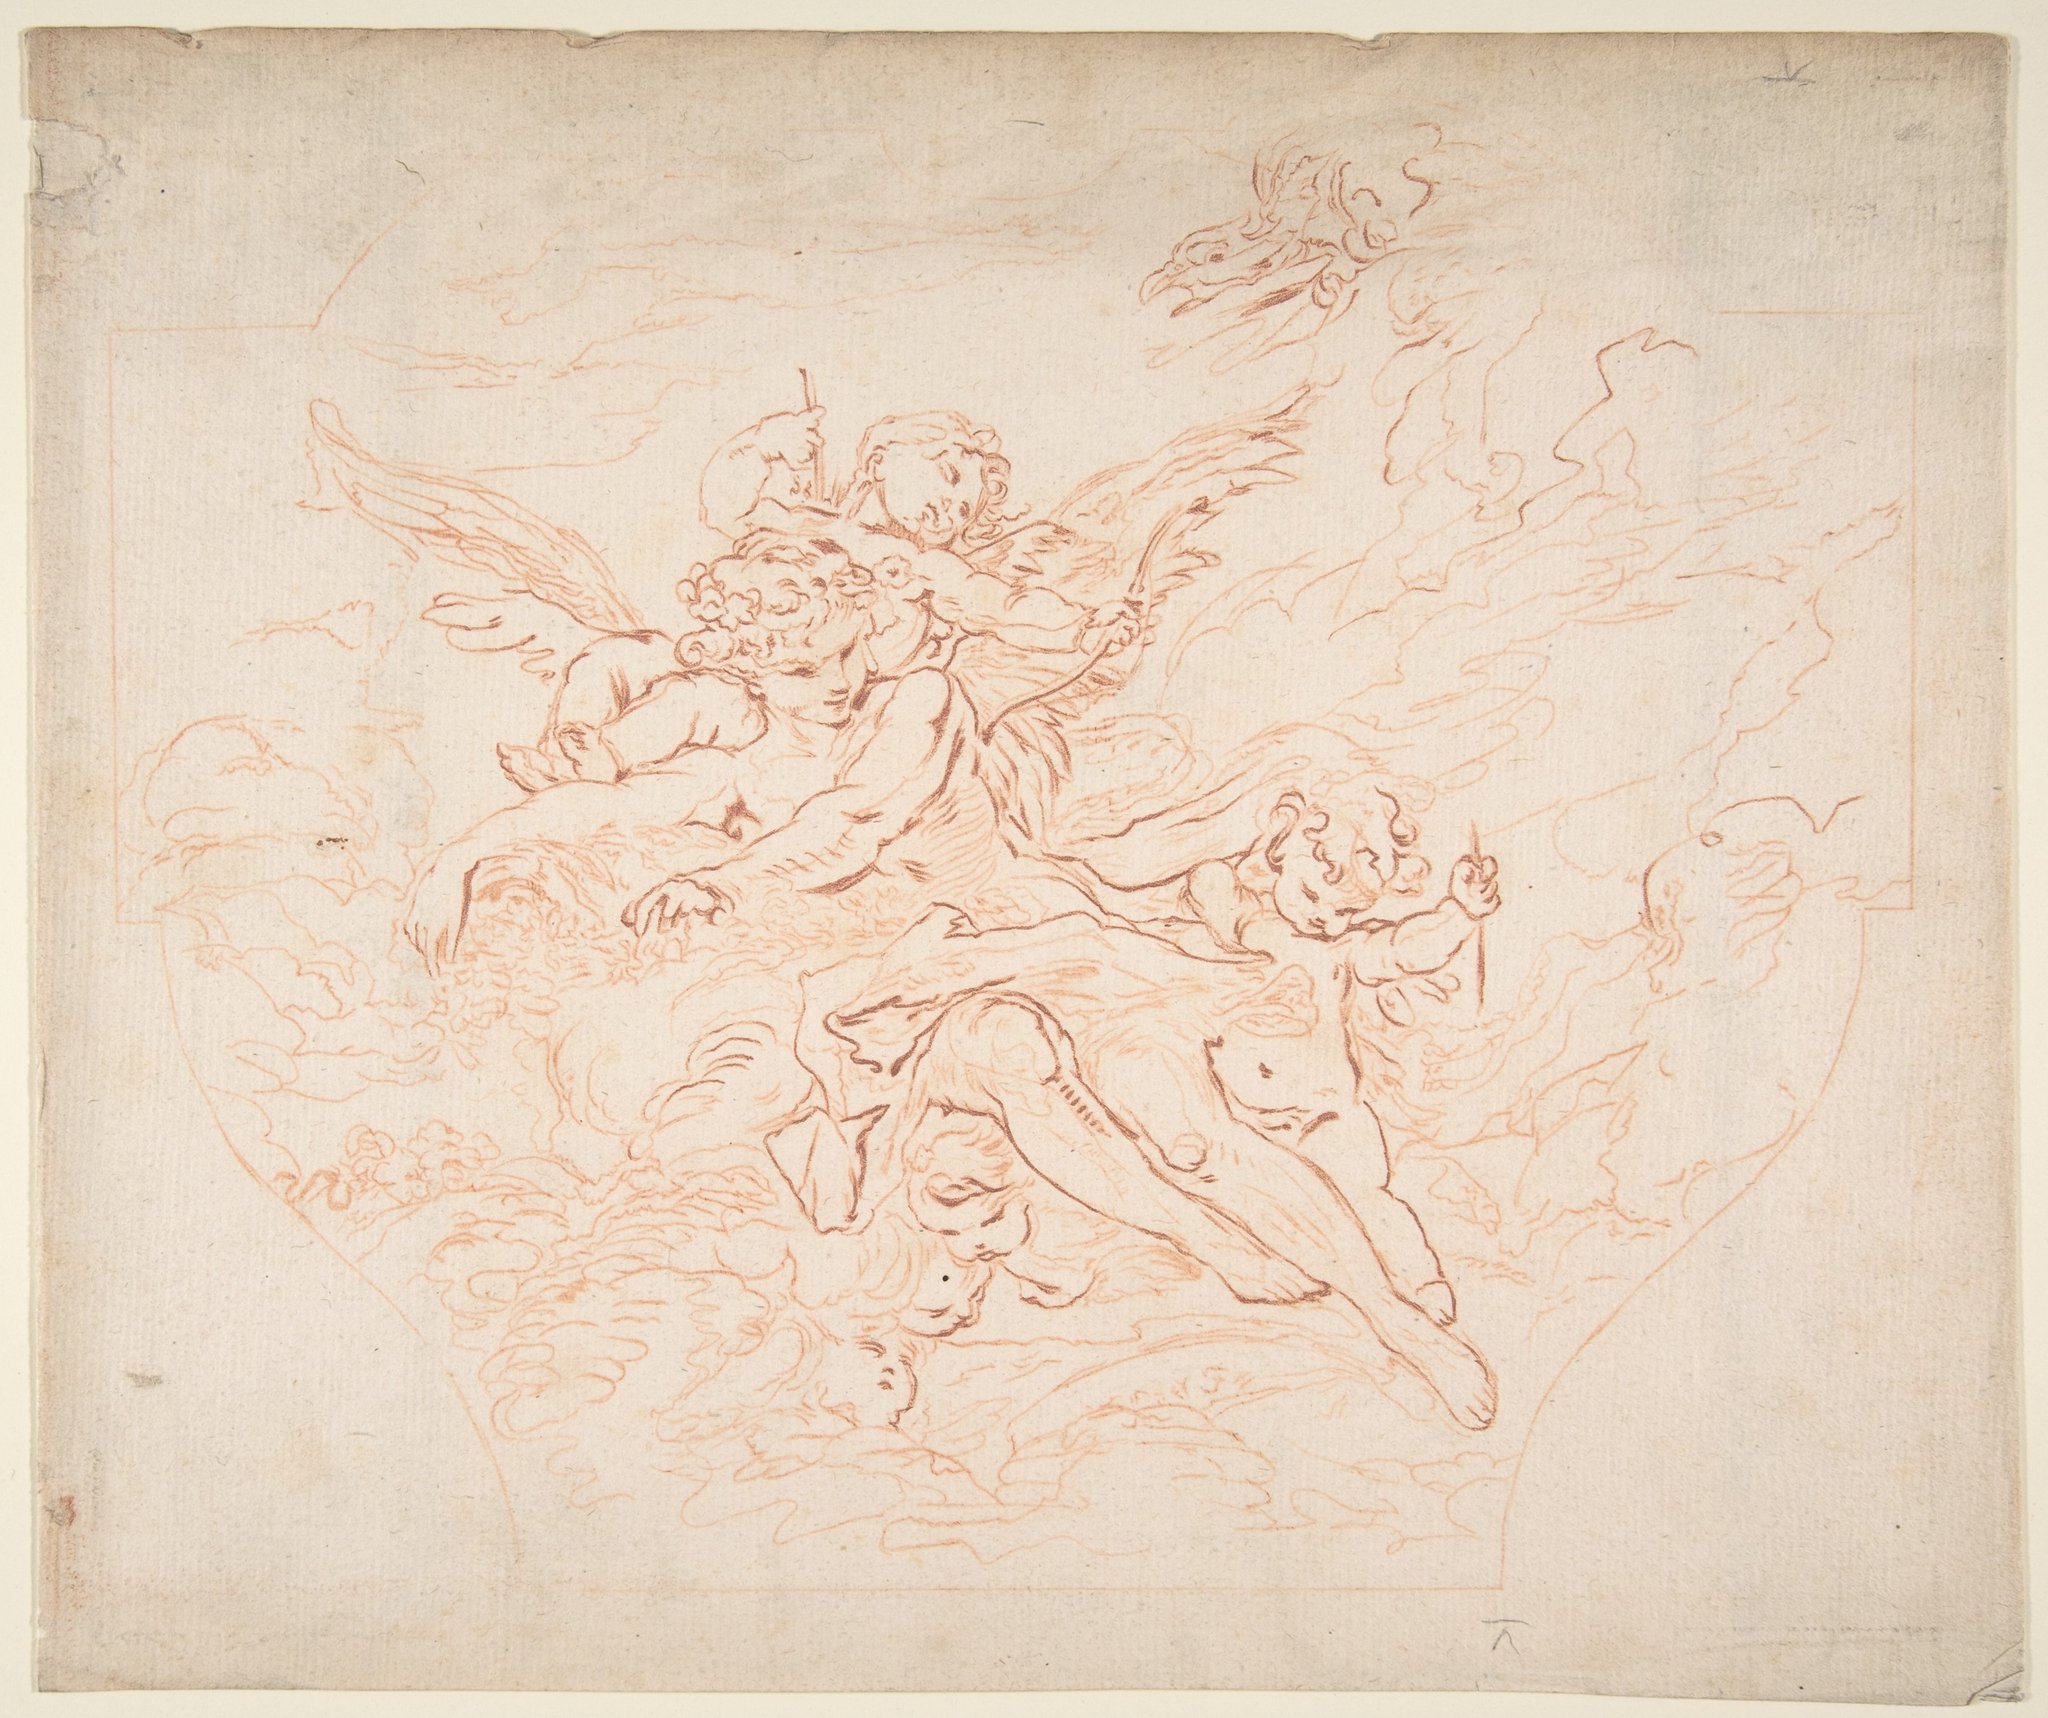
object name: drawing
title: Preparatory Drawing of a Ceiling for Etching, after Boucher Drawing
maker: jean charles françois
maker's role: artist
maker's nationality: french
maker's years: 1717-1769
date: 1734-1766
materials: chalk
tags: birds